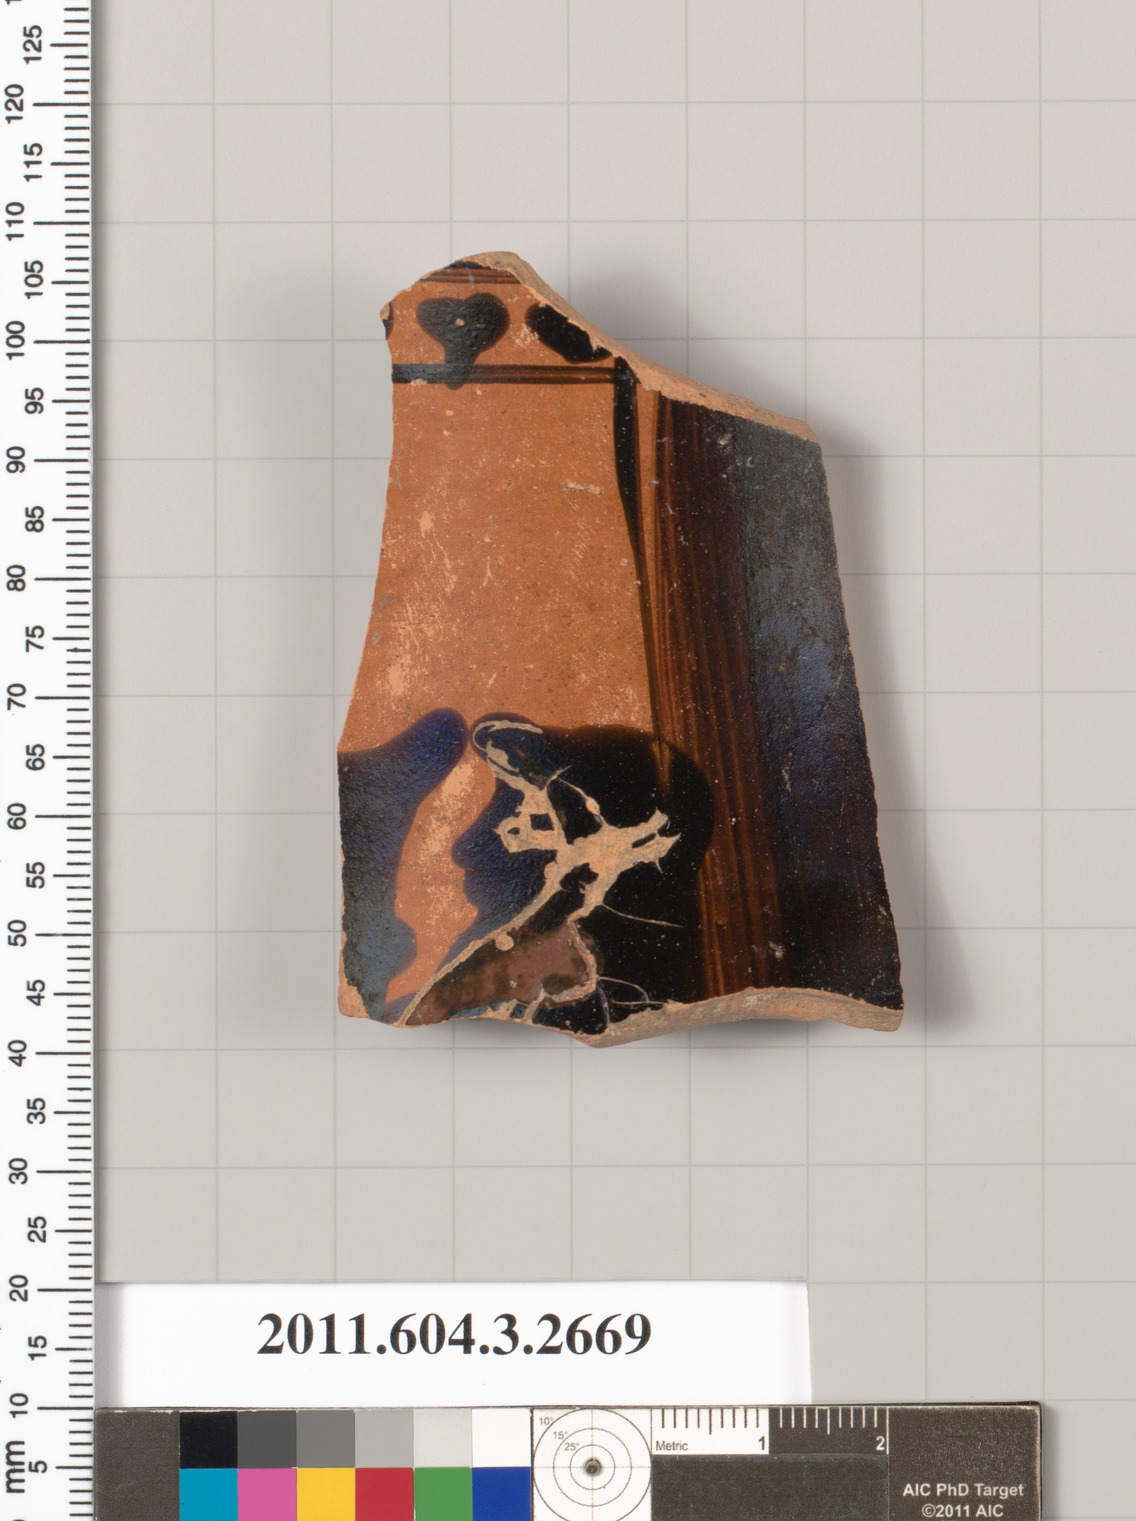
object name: olpe fragment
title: Terracotta fragment of an olpe (jug)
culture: greek, attic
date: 534-468 BCE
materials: terracotta